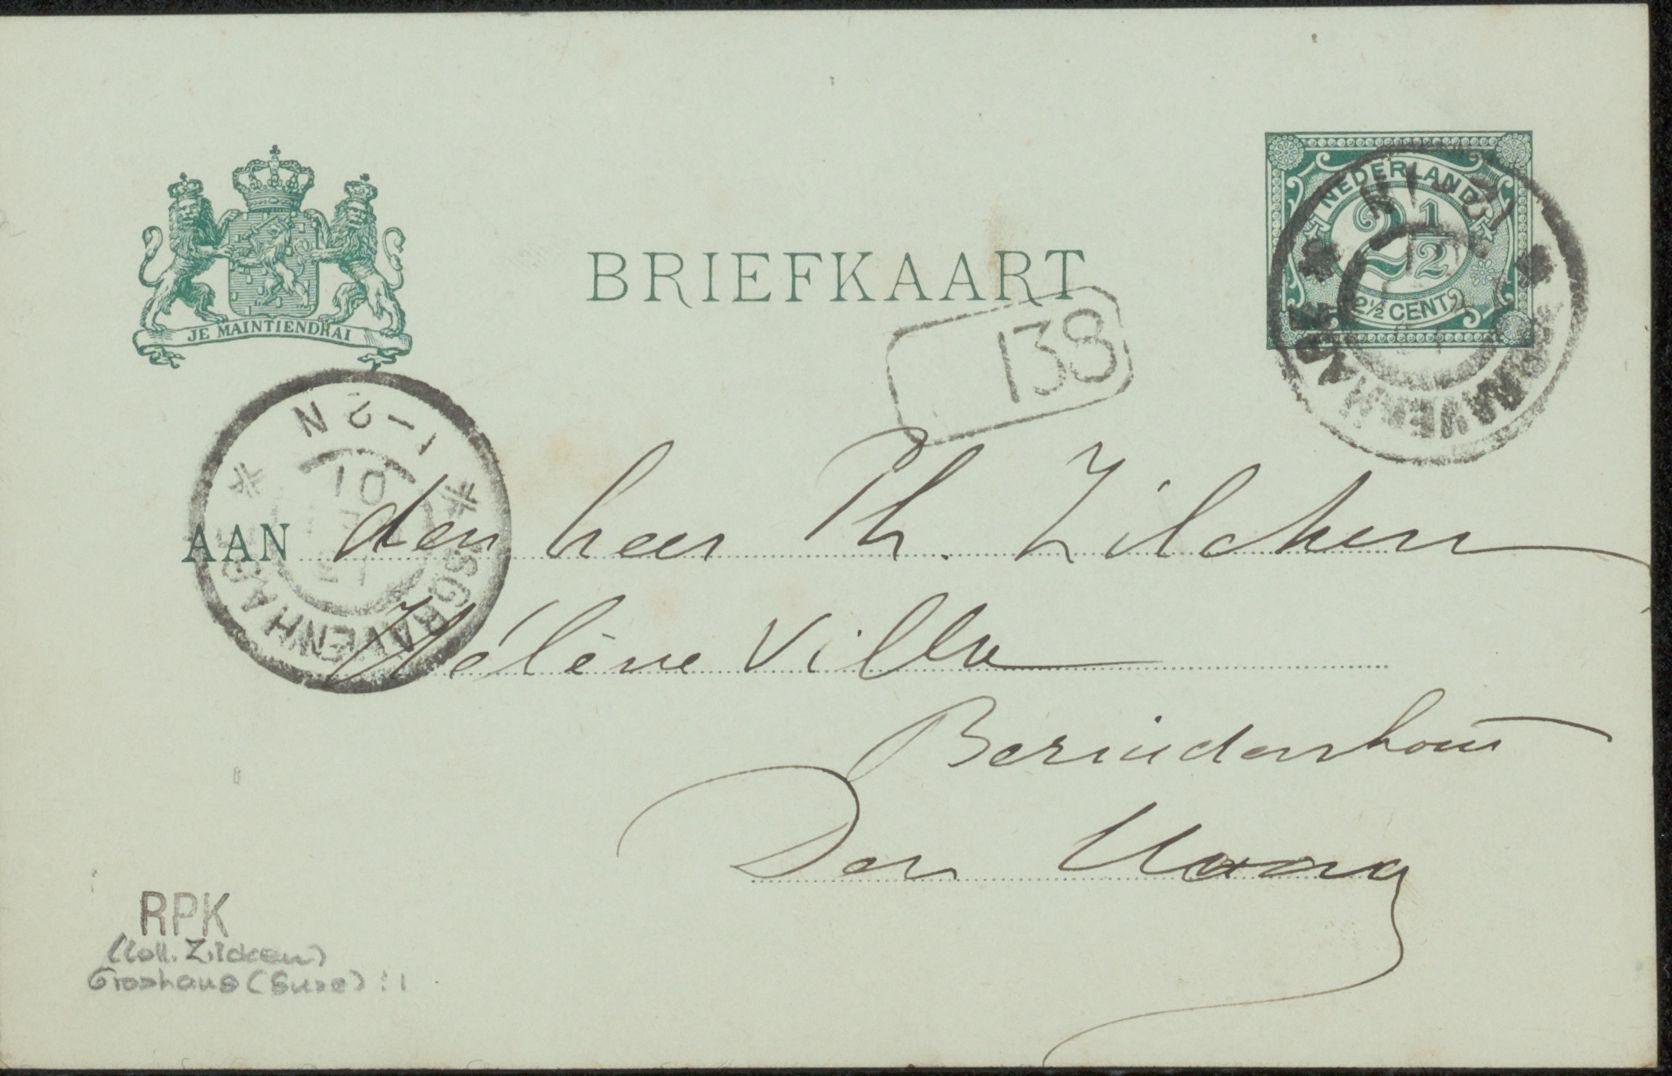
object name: postcard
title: Briefkaart aan Philip Zilcken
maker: suze groshans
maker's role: schrijver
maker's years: 1863-1944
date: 1901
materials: cardboard, ink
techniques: pen, writing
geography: the hague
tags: the hague, painter, draughtsman, philip zilcken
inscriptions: collector's mark: ‘RPK’